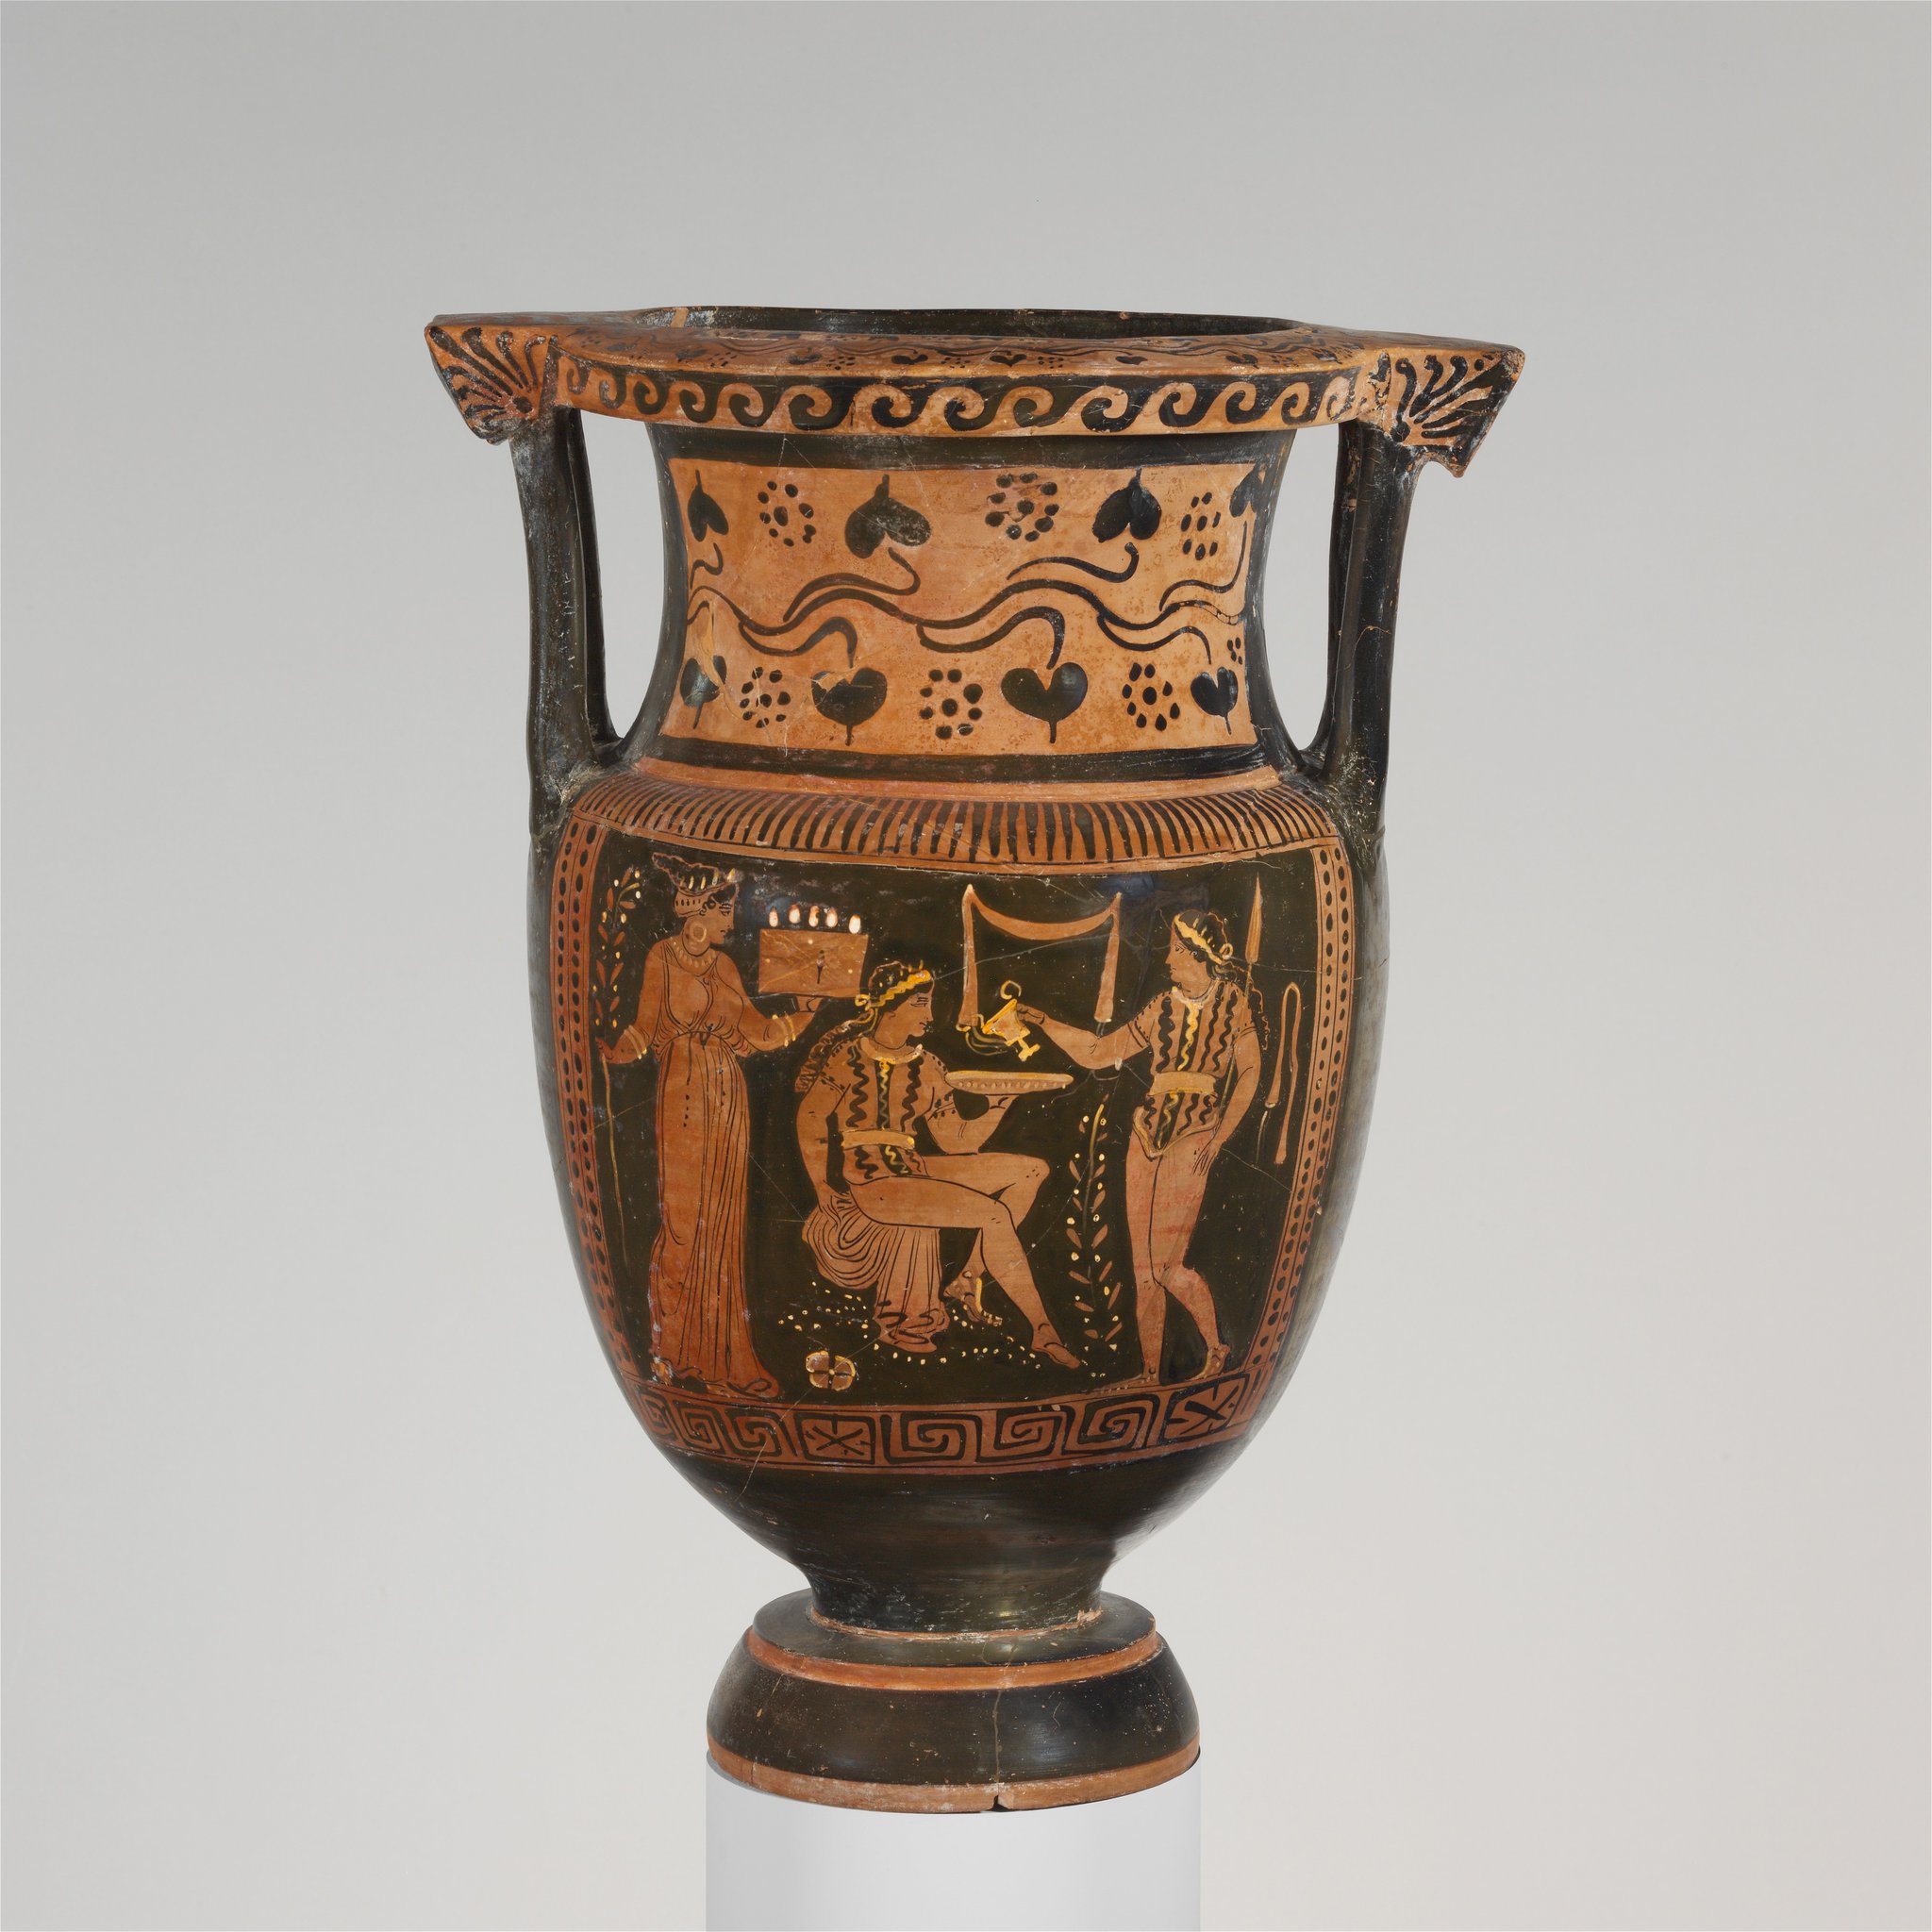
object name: column krater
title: Terracotta column-krater (mixing bowl)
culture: greek, south italian, apulian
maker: rueff painter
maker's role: artist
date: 400-301 BCE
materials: terracotta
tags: men,women